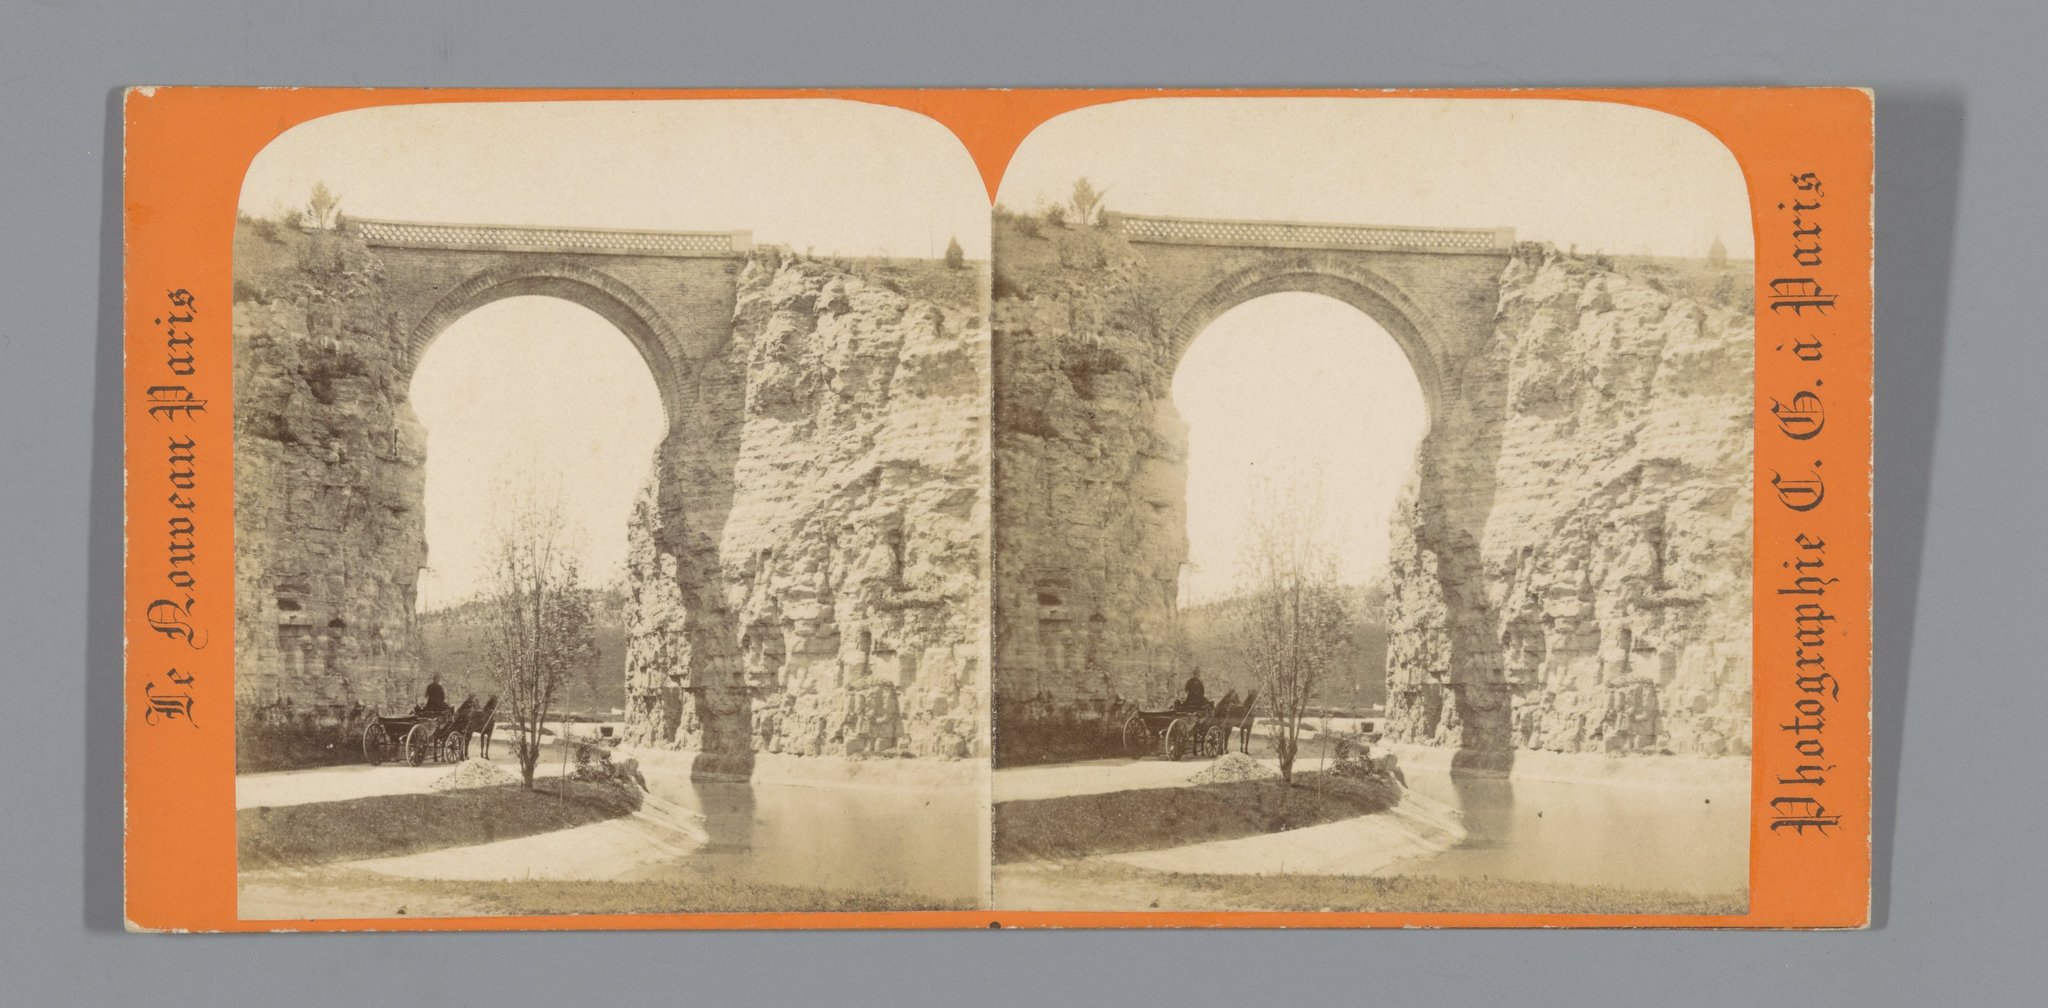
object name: stereograph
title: Le Nouveau Paris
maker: charles gérard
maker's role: fotograaf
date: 1860-1870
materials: cardboard, photographic support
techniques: albumen print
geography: parc des buttes-chaumont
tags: park, bridge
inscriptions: inscription: ‘Photographie C. G. à Paris.’, inscription: ‘Buttes Chaumont’